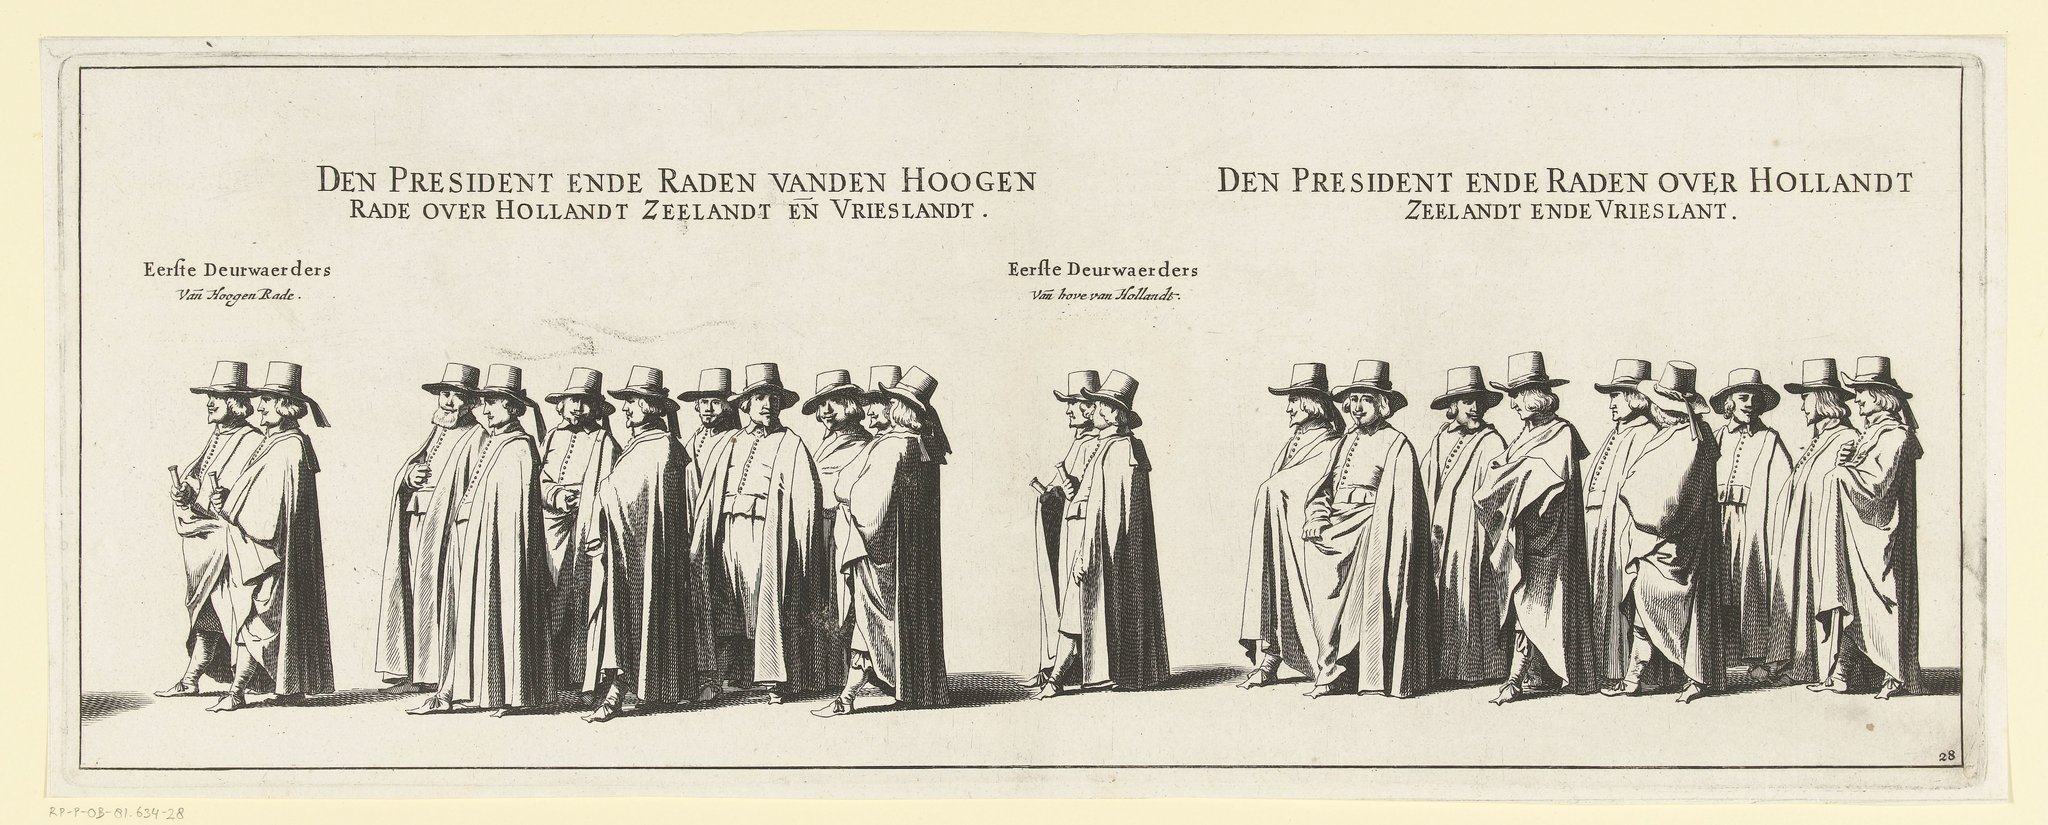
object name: print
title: De begrafenisstoet van stadhouder Frederik Hendrik te 's-Gravenhage in 1647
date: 1647-1651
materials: paper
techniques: etching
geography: the hague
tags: delft, frederick henry (prince of orange), cortege, funeral procession, the hague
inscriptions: collector's mark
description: De begrafenisstoet van stadhouder Frederik Hendrik te 's-Gravenhage op 10 mei 1647. Plaat nr. 28 met een deel van de stoet met leden van de raden van Holland, Zeeland en Friesland, boven de personen staat hun functie. Onderdeel van een serie van 30 platen en 20 tekstbladen, bedoeld om aan elkaar geplakt te worden.